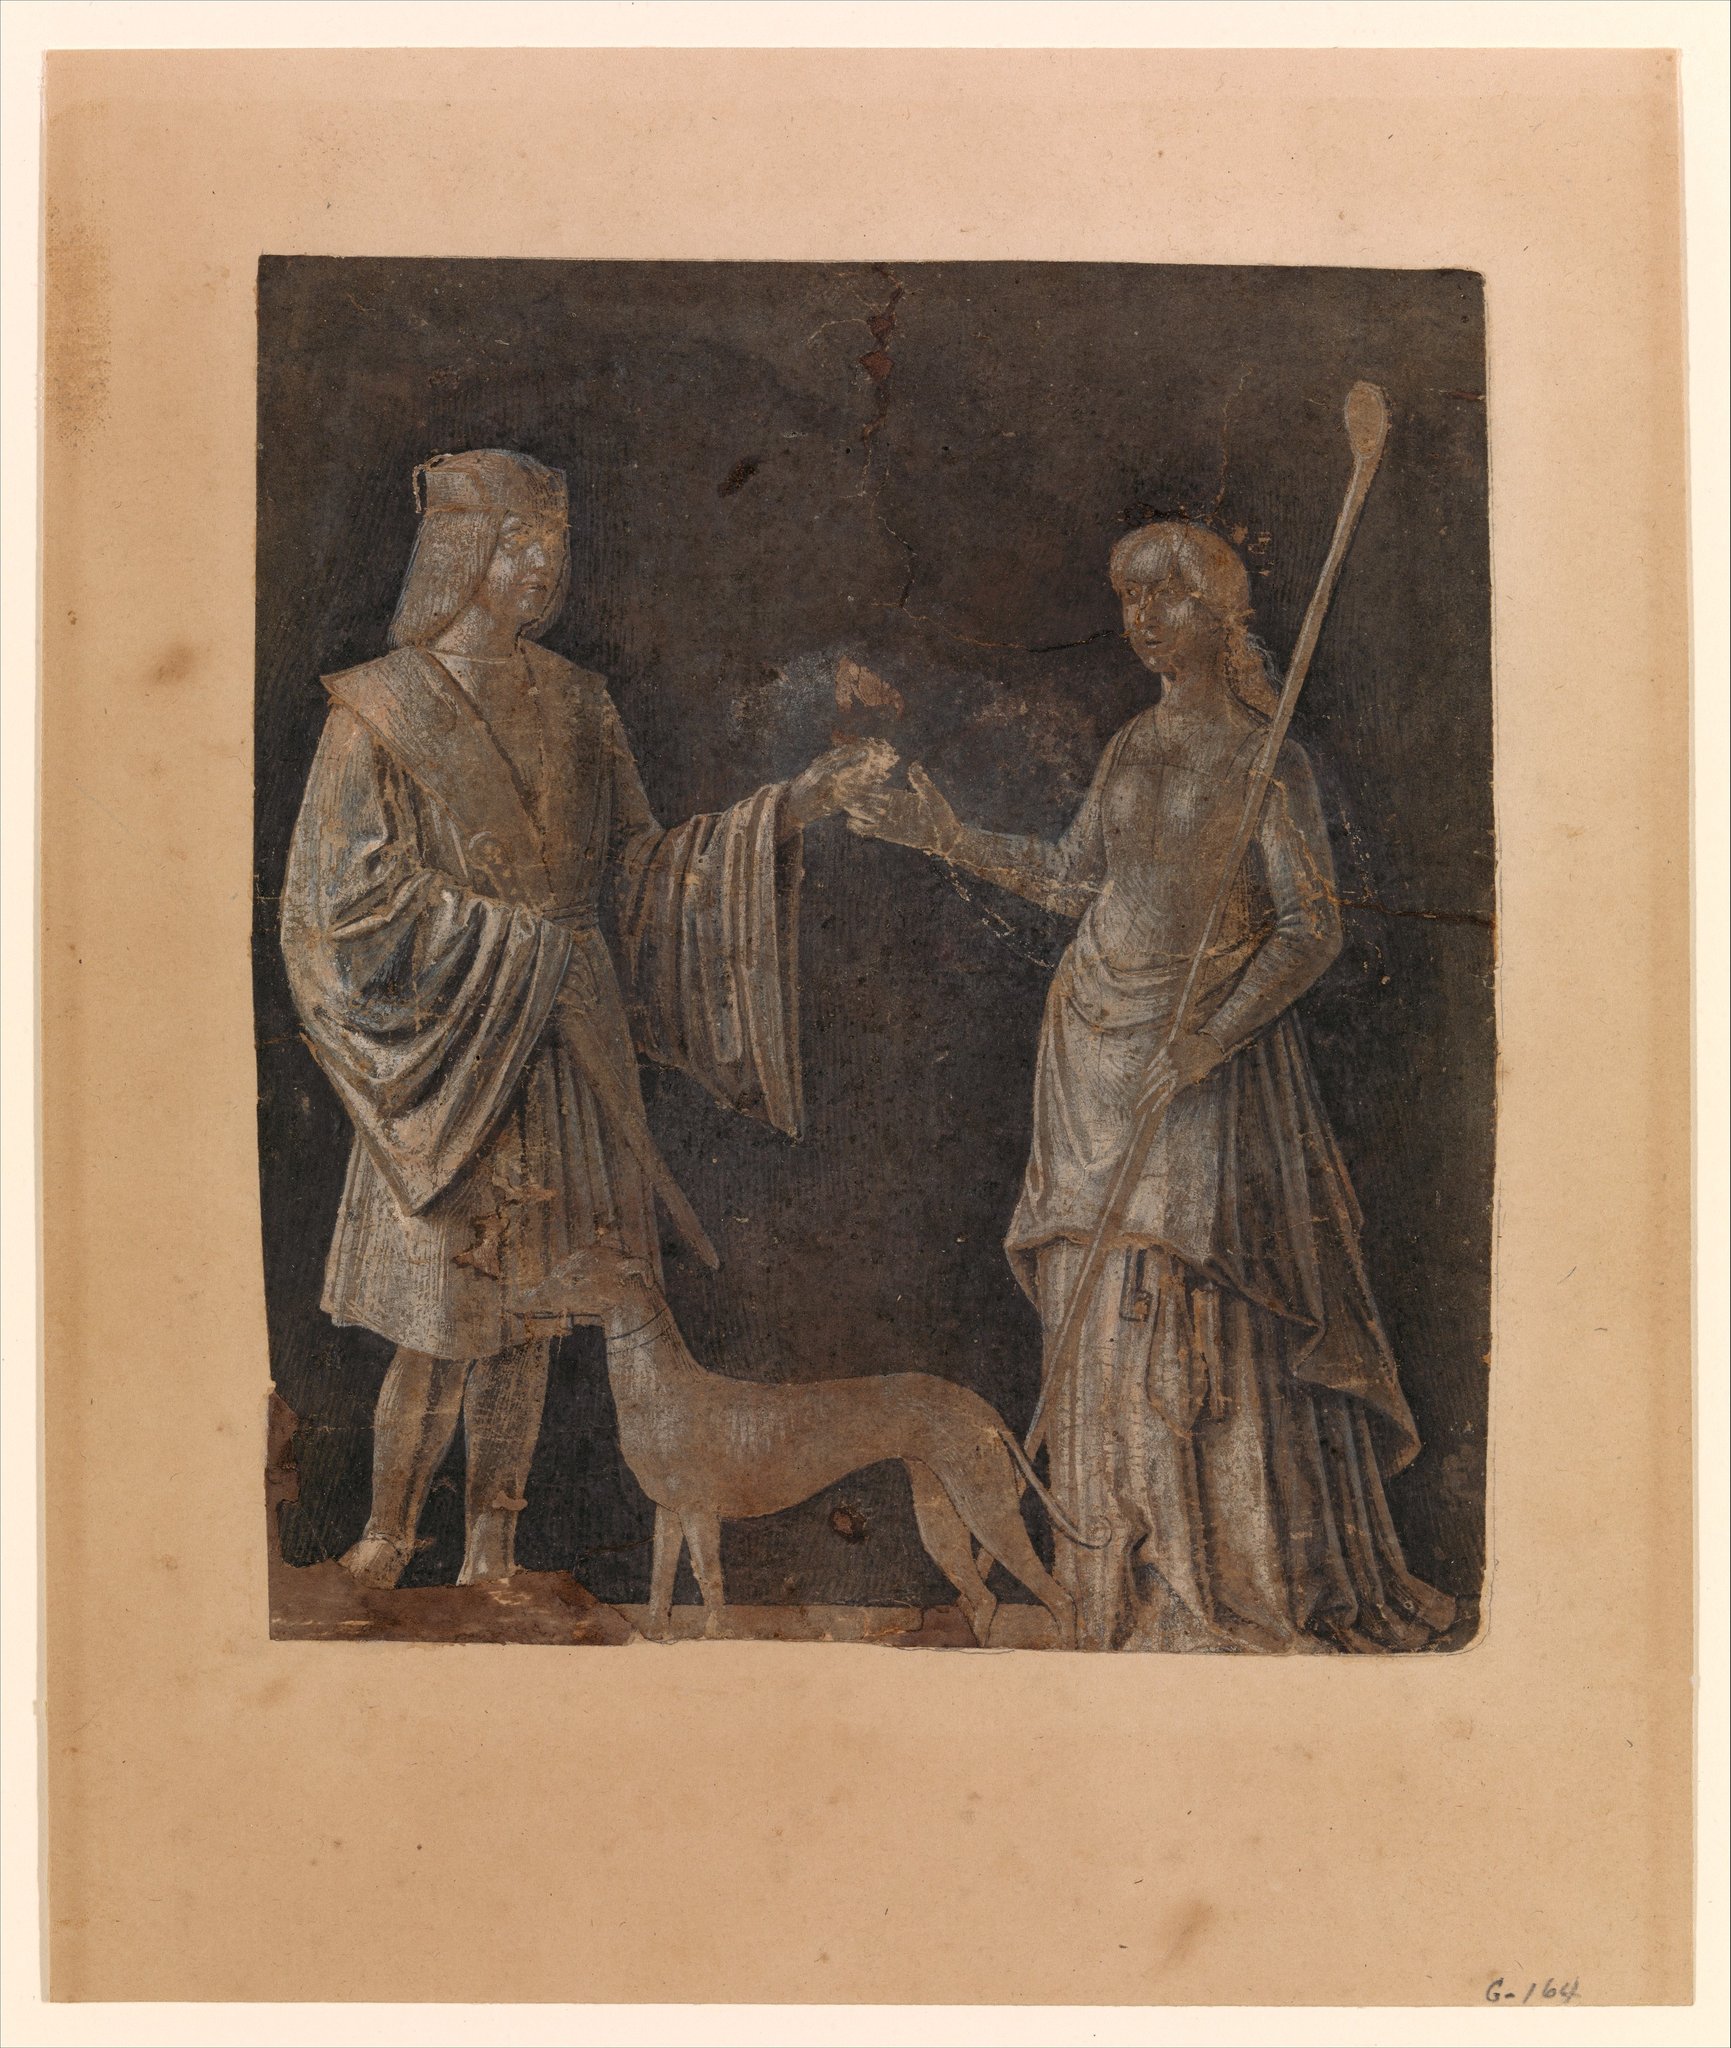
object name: drawing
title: A Gentleman, a Young Woman, and a Dog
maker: michele da verona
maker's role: artist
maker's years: 1470-1544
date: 1501-1533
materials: ink, paper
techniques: brush, heightening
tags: love,couples,men,women,dogs